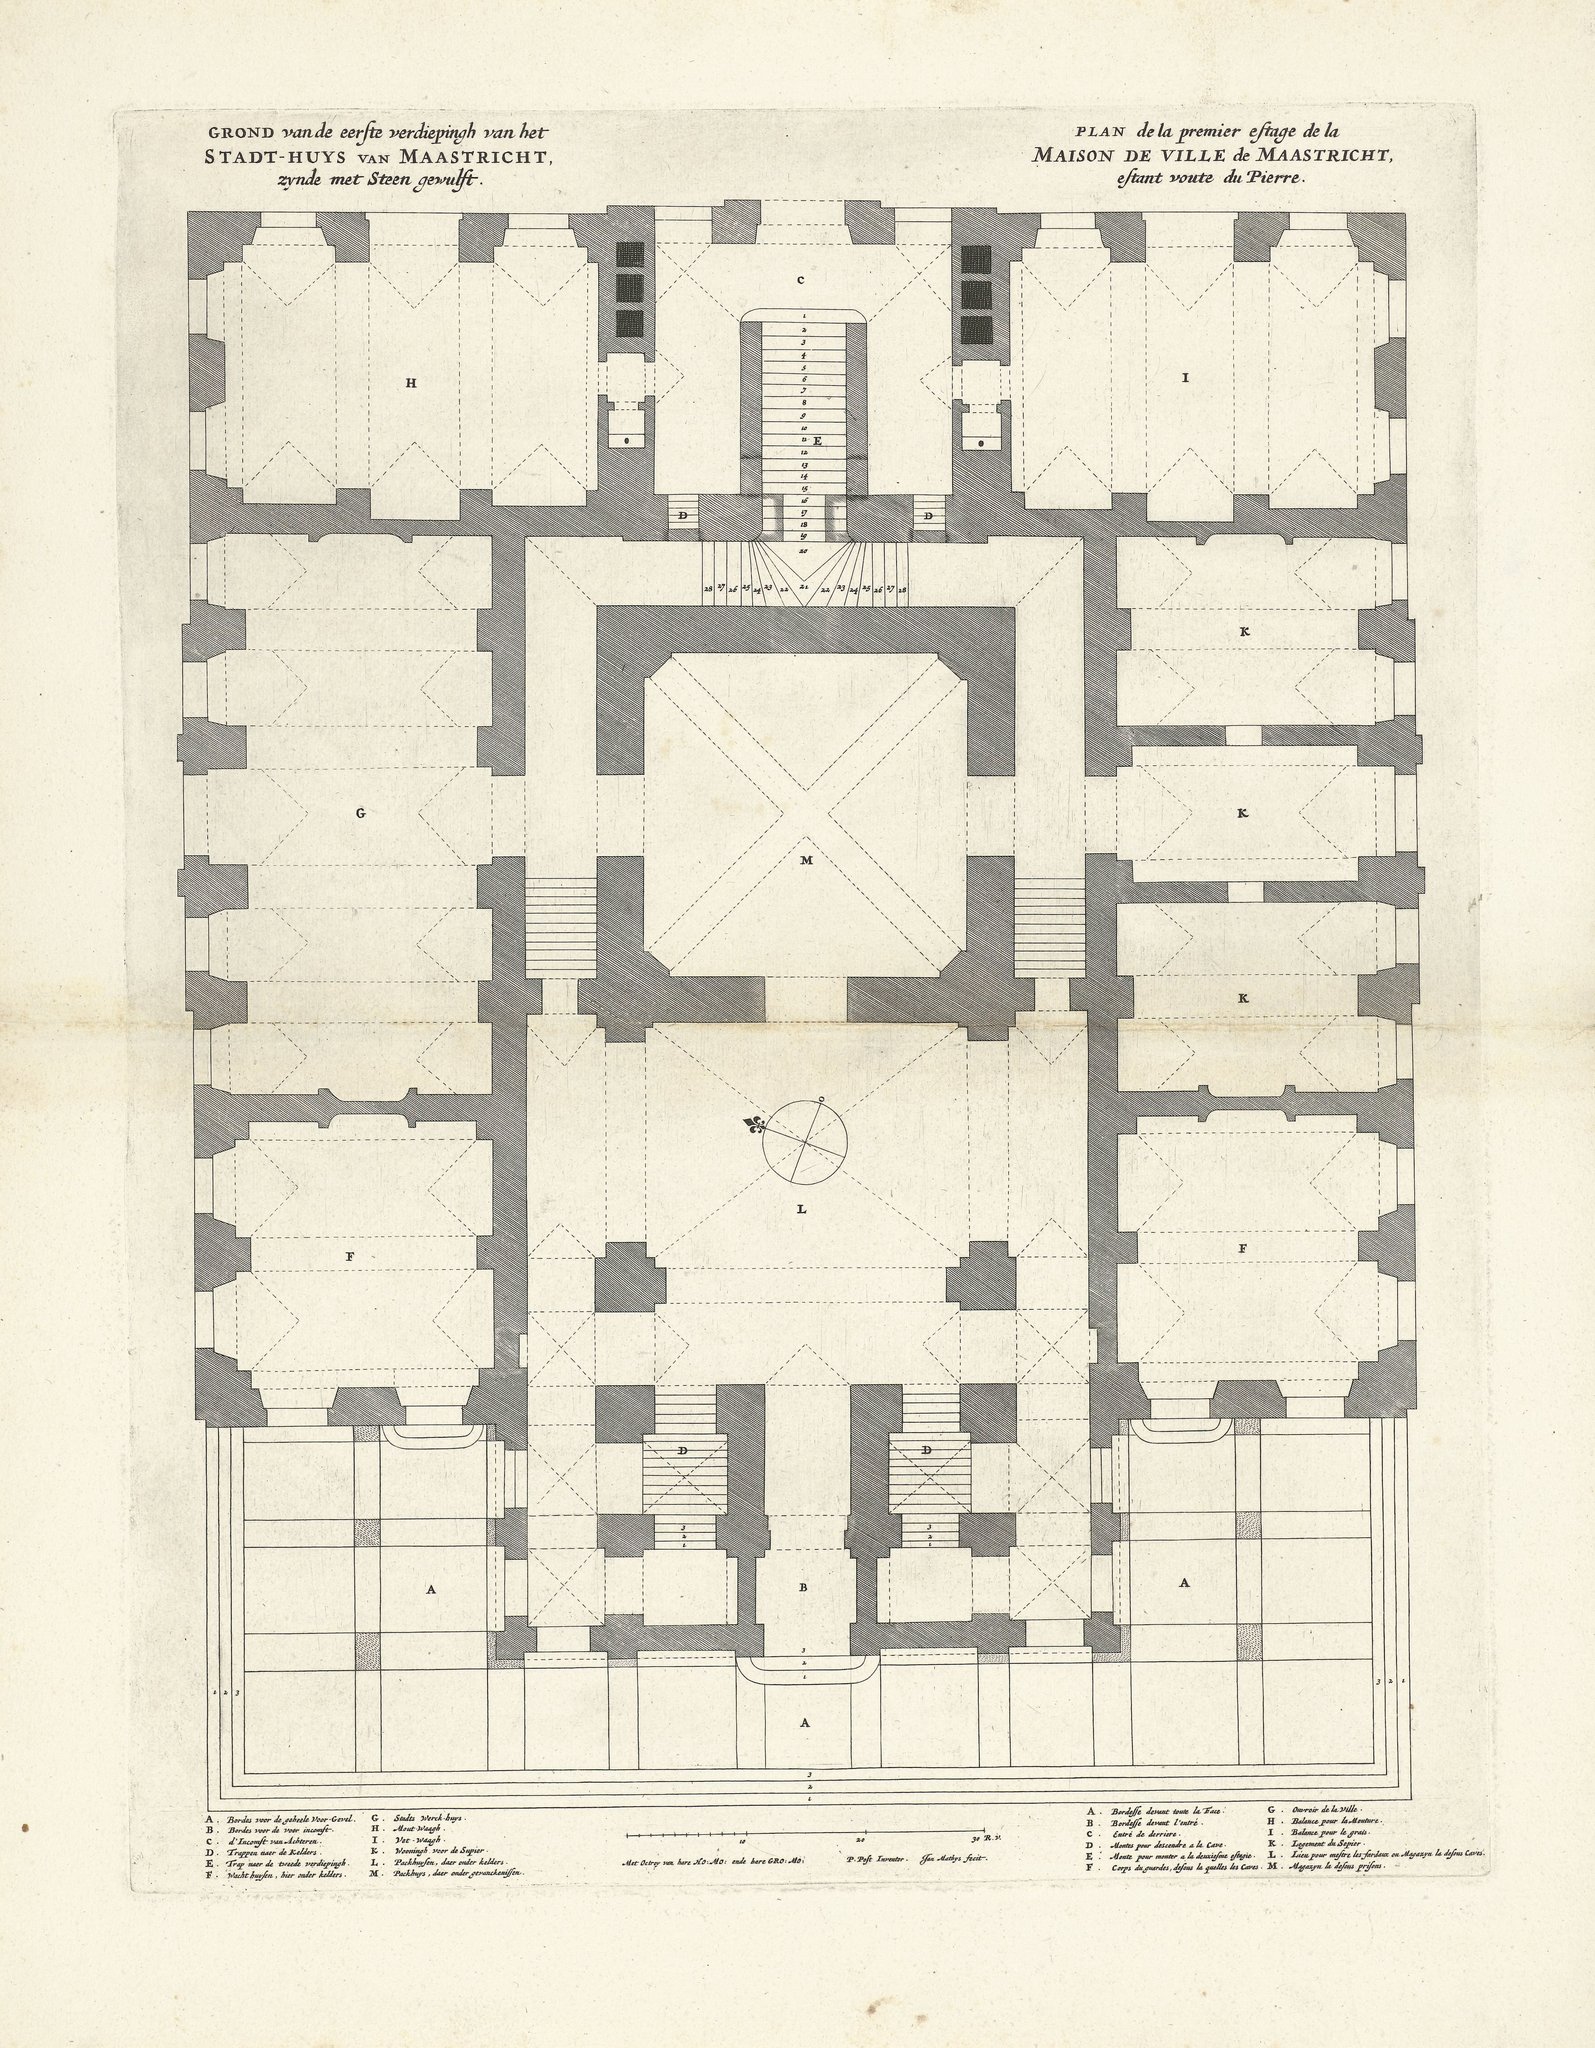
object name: print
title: Grond van de eerste verdiepingh van het stadt-huys van Maastricht zynde met steen gewulft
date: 1664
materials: paper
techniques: engraving, etching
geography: amsterdam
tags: townhall, plan ~ architecture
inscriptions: collector's mark: Lugt 2228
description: Plattegrond van de eerste verdieping van het stadhuis van Maastricht. De stippellijnen geven de gewelven aan. Onderaan een legenda.